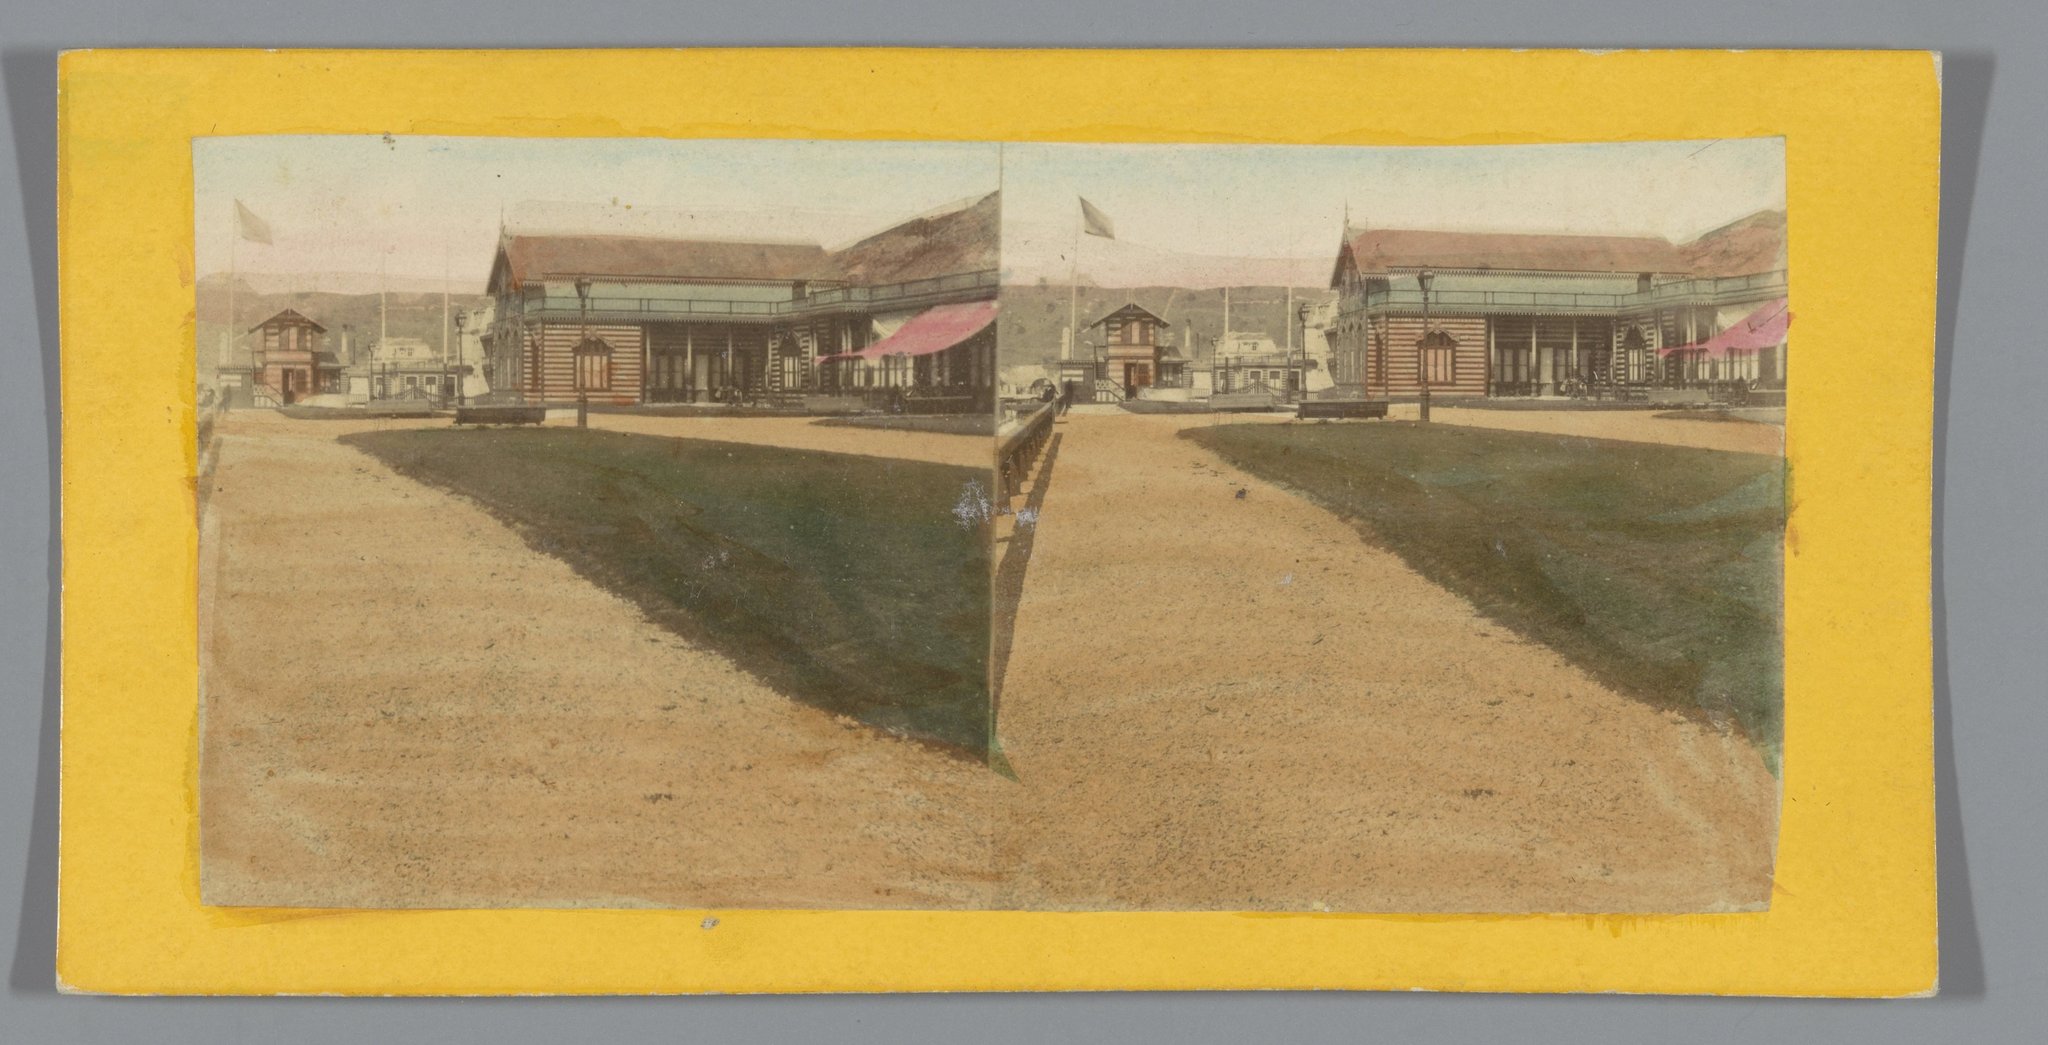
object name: stereograph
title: Exterieur van een badhuis te Fécamp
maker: Anonymous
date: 1860-1880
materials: cardboard, photographic support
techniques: albumen print, hand coloring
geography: fecamp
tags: public baths, façade (of house or building)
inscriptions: inscription: ‘Bains de mer de Fecamp’